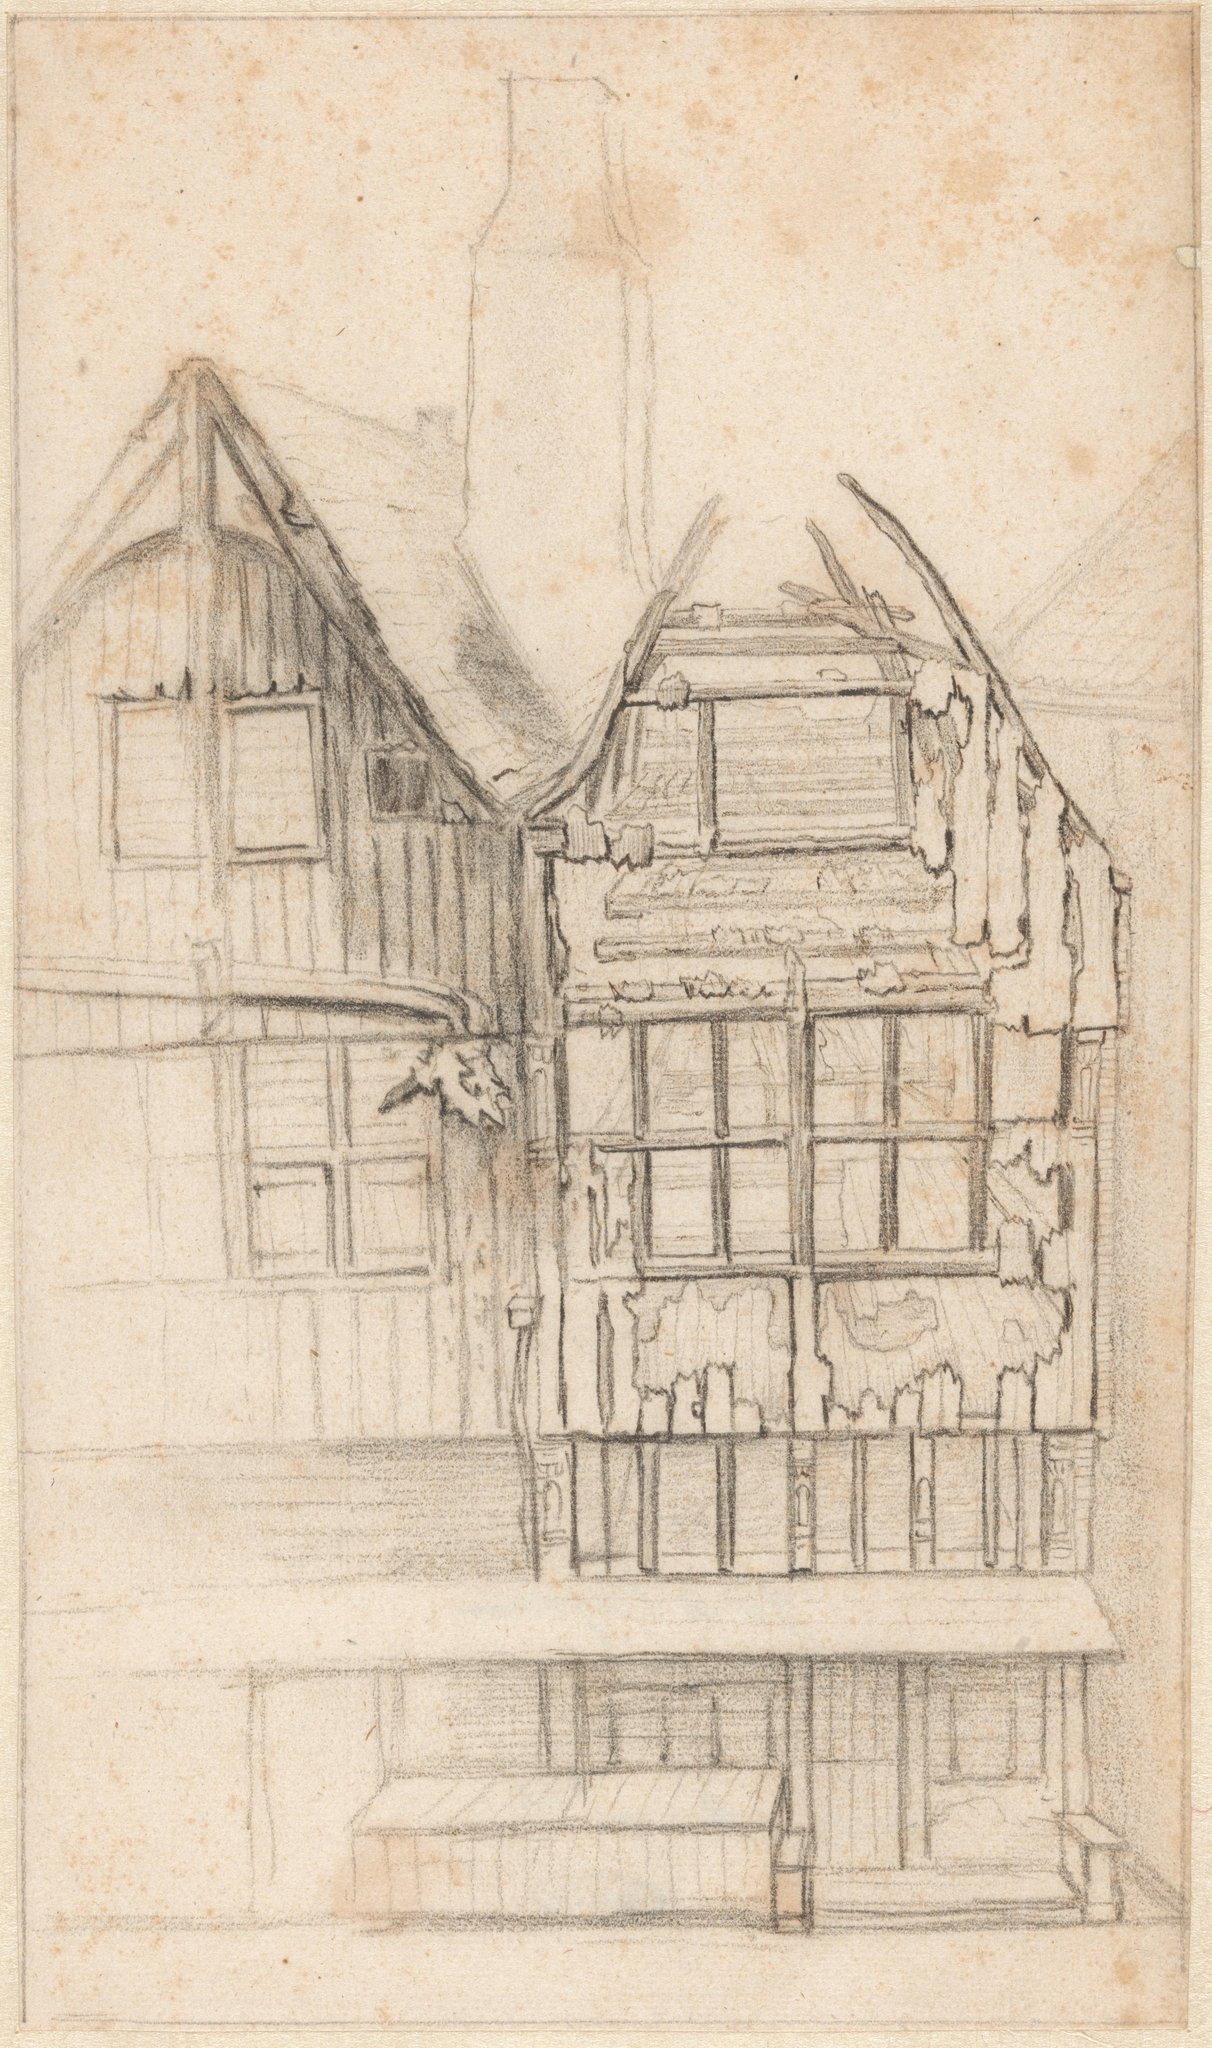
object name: design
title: Twee uitgebrande huizen in de Oude Nieuwstraat, 1682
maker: jan van der heyden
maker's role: draughtsman, painter, print maker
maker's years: 1637-1712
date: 1682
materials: chalk, paper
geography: amsterdam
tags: amsterdam, draughtsman, jan van der heyden, urban housing, ruin of a building ~ architecture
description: Ontwerptekening voor illustratie in: Heyden, Jan van der. Beschryving der nieuwlyks uitgevonden en geoctrojeerde slang-brand-spuiten en haare wyze van brand-blussen, tegenwoordig binnen Amsterdam in gebruik zijnde (…). 1e druk. Amsterdam: Jan Rieuwertsz. (II), 1690. En: Heyden, Jan van der. Beschryving der nieuwlyks uitgevonden en geoctrojeerde slang-brand-spuiten en haare wyze van brand-blussen, tegenwoordig binnen Amsterdam in gebruik zijnde (…). 2e druk. Amsterdam: erfgenamen Jan van der Heyden, 1735. Voor de prent zie RP-P-OB-82.088.